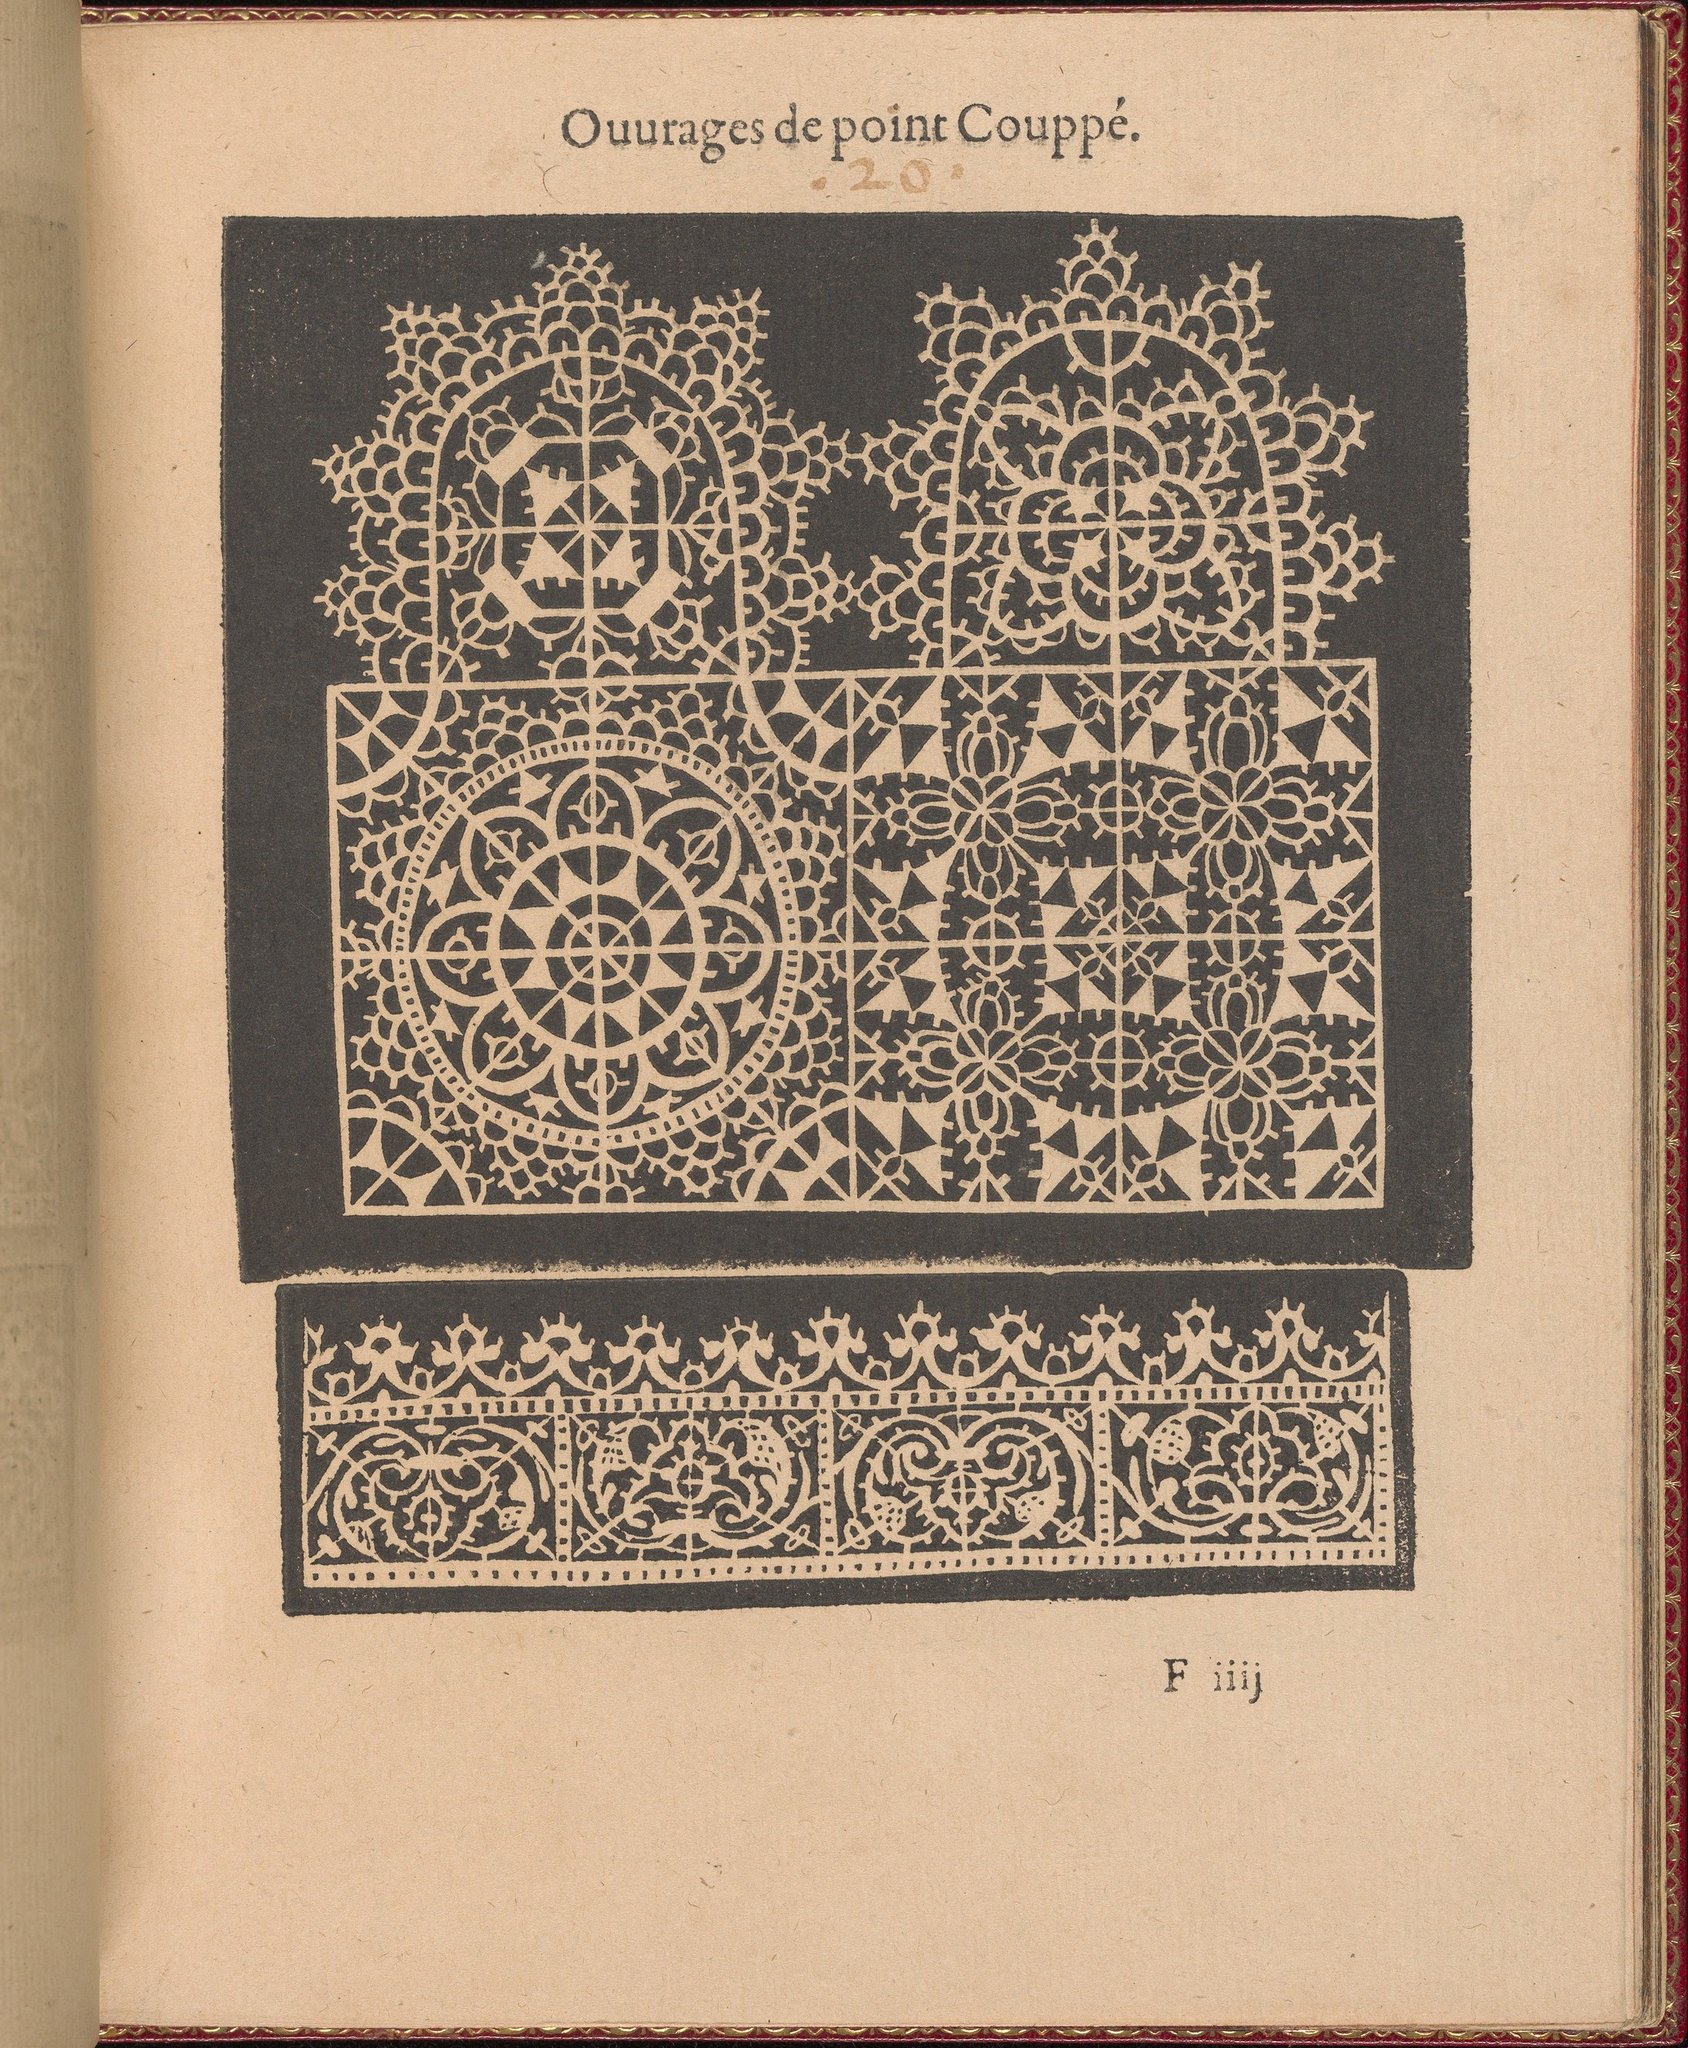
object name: book print ornament architecture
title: Les Singuliers et Nouveaux Portraicts... page 24 (recto)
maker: federico de vinciolo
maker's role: designer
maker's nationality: italian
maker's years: 1582-1599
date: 1588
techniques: woodcut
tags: flowers,vines